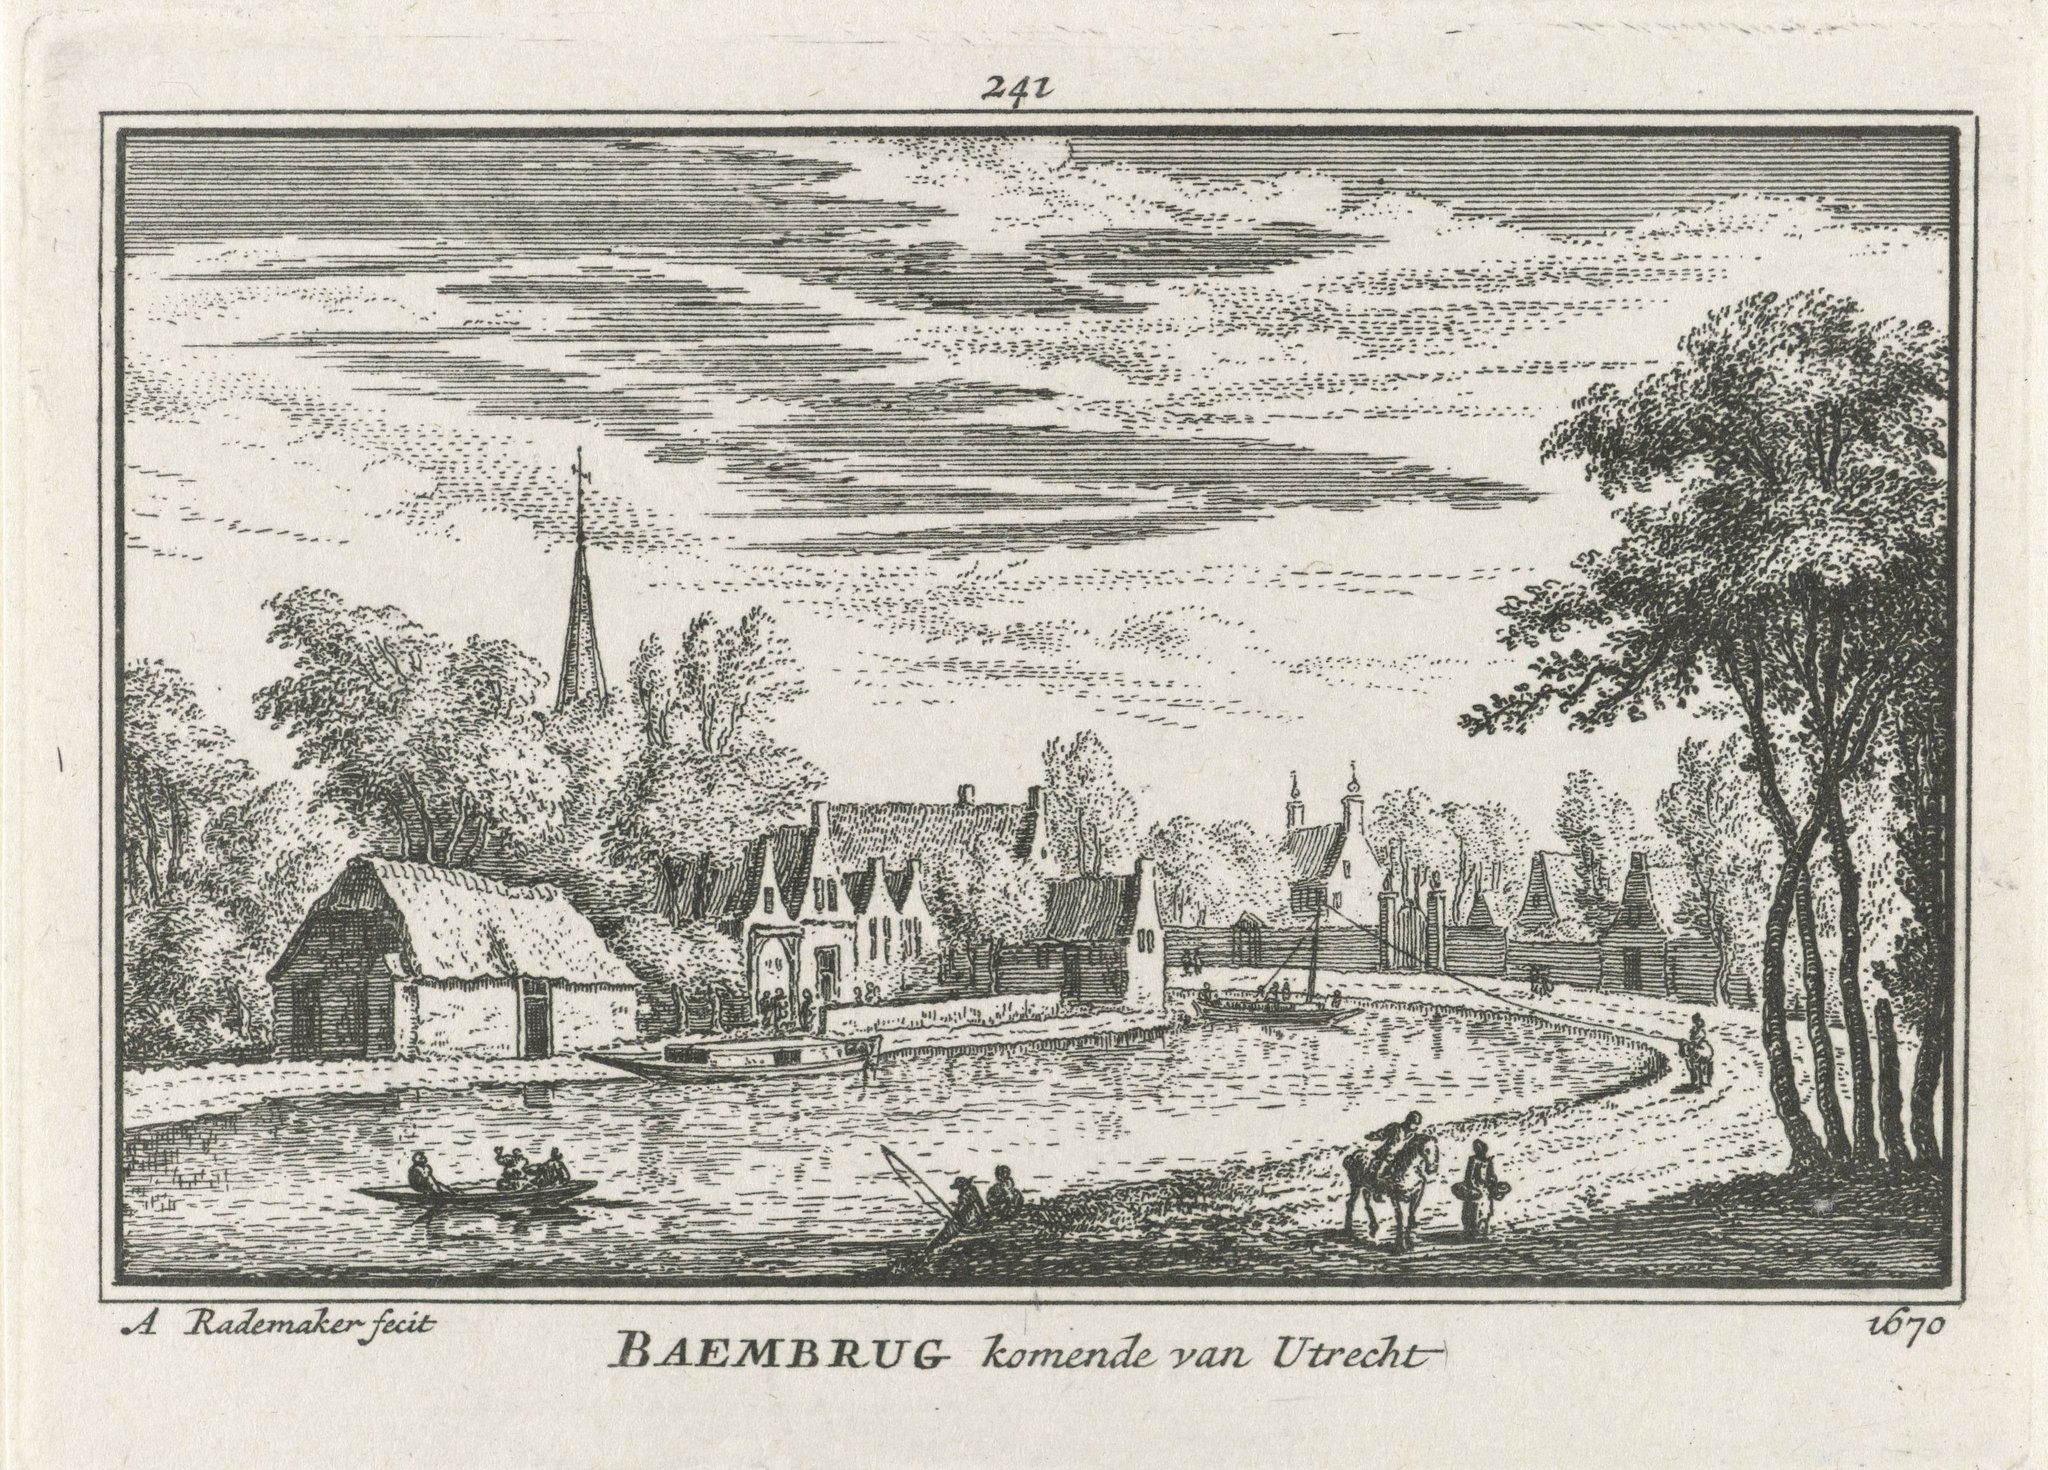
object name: book illustration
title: Gezicht op Baambrugge, 1670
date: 1727-1733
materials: paper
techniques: etching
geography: amsterdam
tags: riding a horse, ass, or mule; rider, horseman, prospect of village, silhouette of village, sailing-ship, sailing-boat, rowing-boat, canoe, etc., fisherman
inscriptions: collector's mark: Lugt 2228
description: Illustratie uit: Abraham Rademaker, Matthaeus Brouërius van Niedek, Isaac Le Long, Kabinet van Nederlandsche en Kleefsche outheden en (...) voorname stads- en landgebouwen, Willem Barents en Antoni Schoonenburg: Amsterdam, 1727-1733, ill. nr. 292.